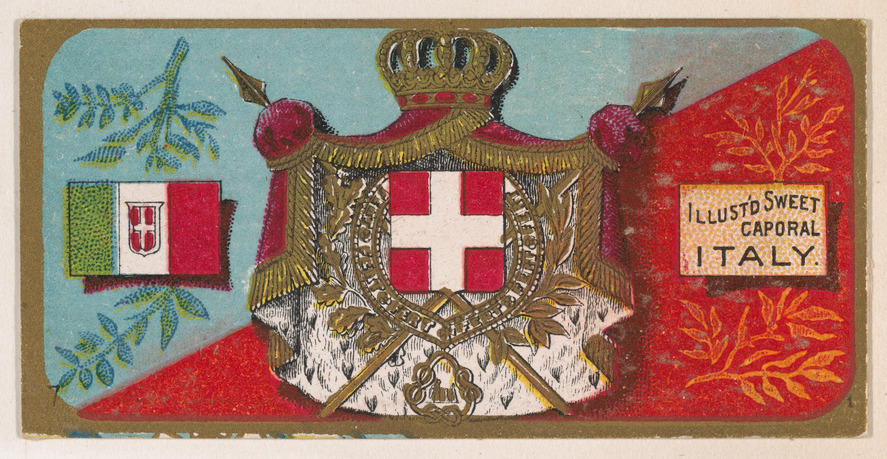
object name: print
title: Coat of Arms, Italy, from the Military Series (N224) issued by Kinney Tobacco Company to promote Sweet Caporal Cigarettes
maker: kinney brothers tobacco company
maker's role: publisher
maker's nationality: american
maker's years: 1869-2011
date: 1888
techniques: color lithograph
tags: coat of arms